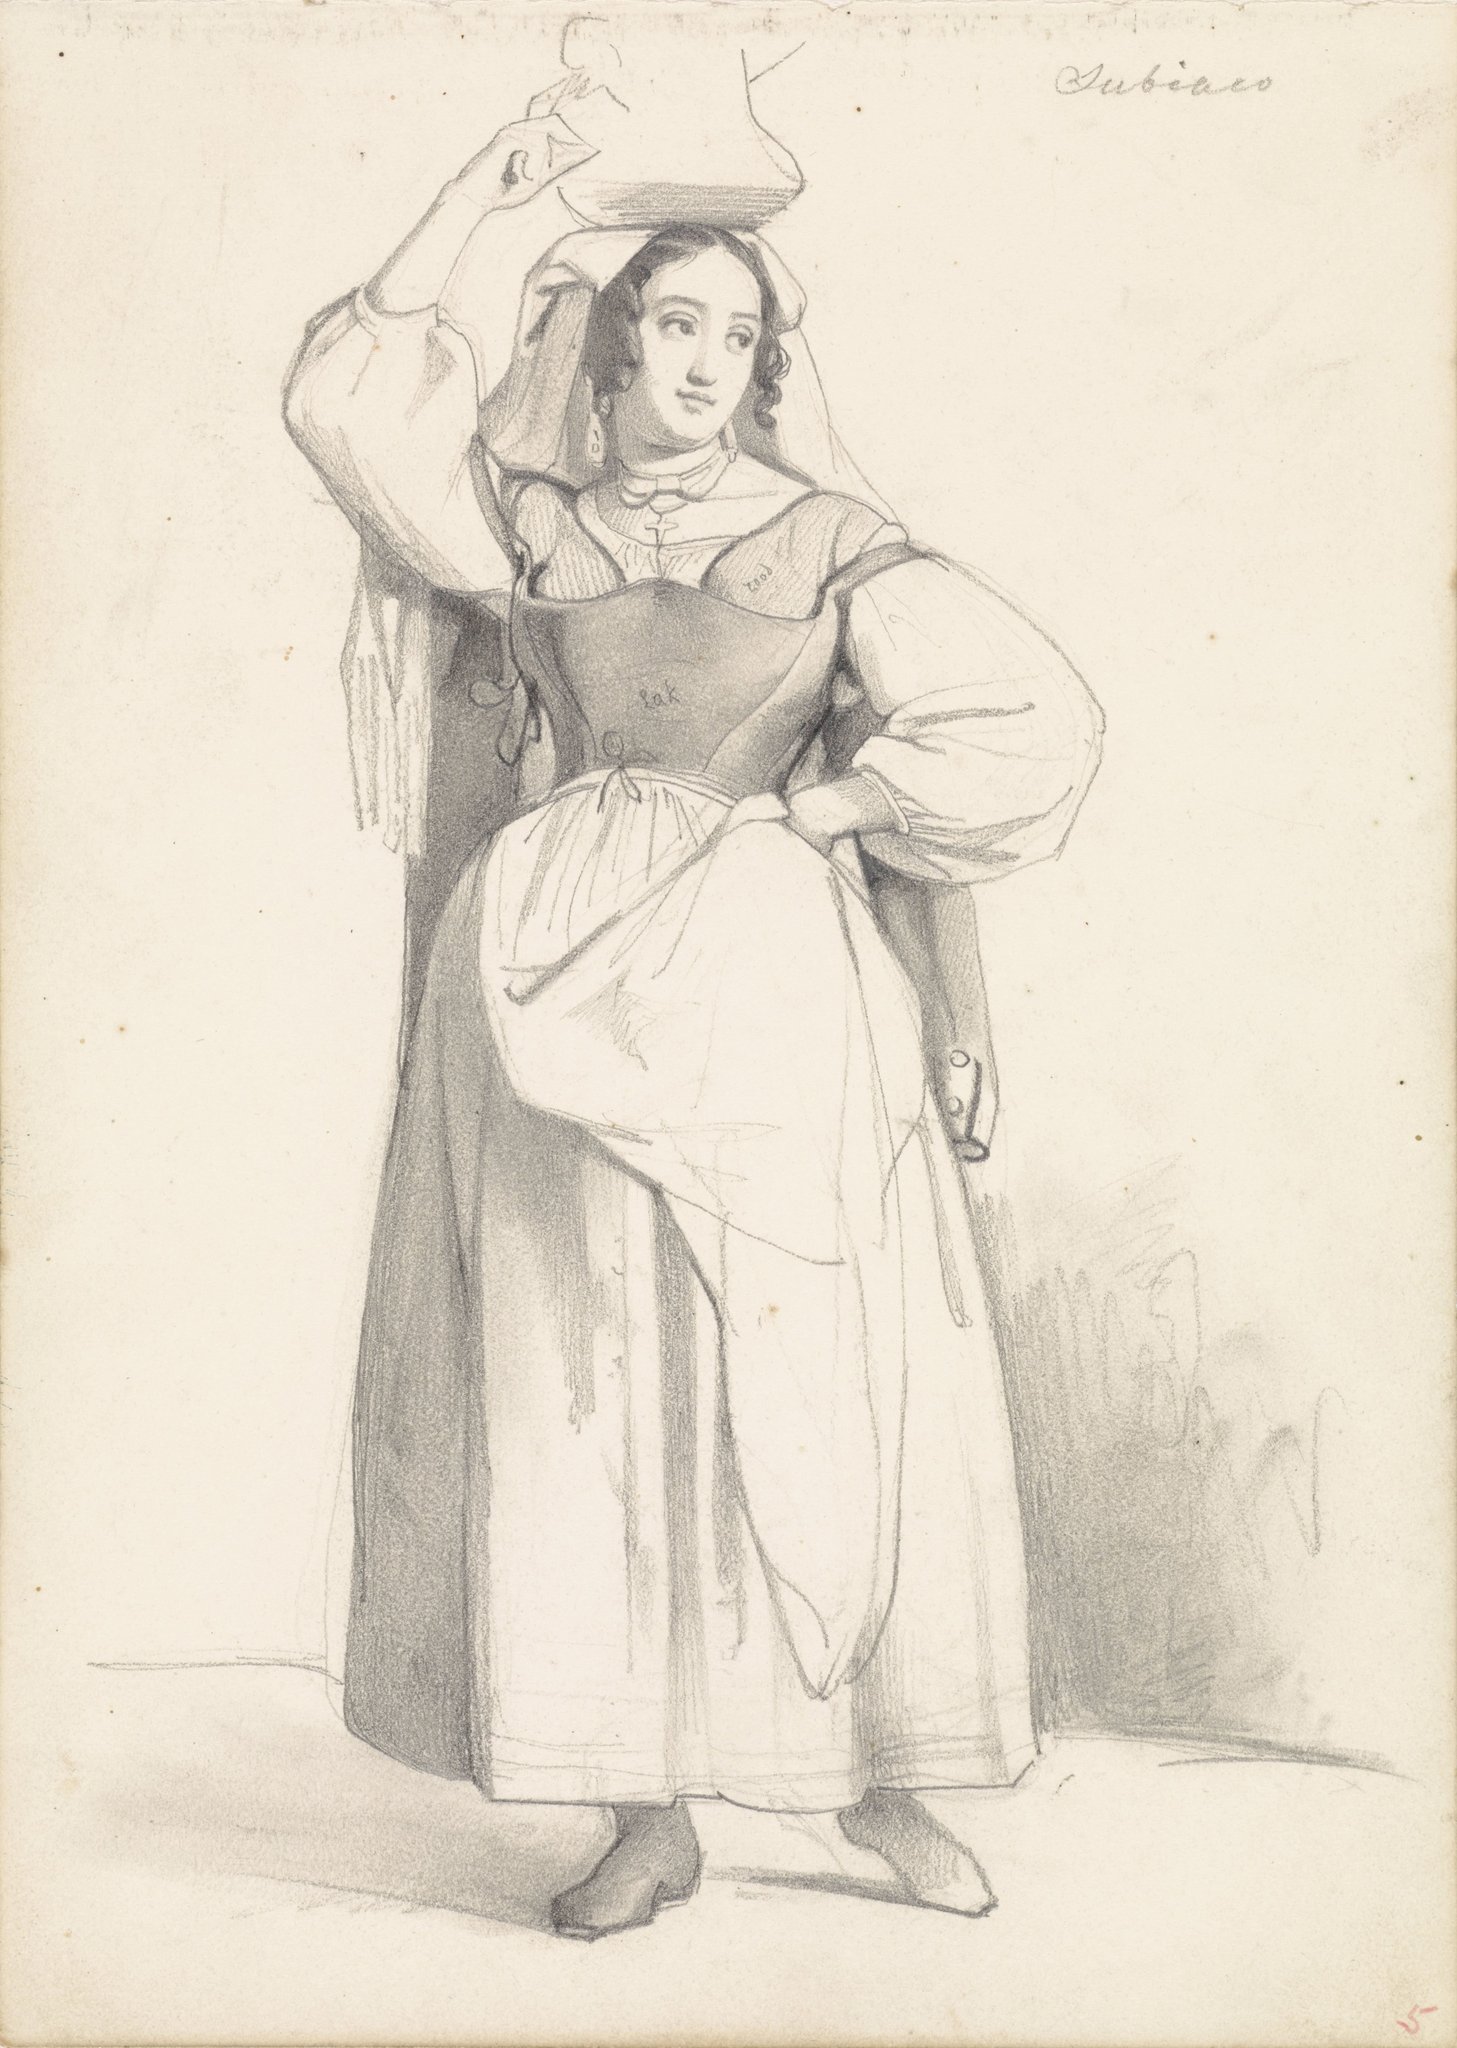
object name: drawing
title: Meisje uit Subiaco, met een koperen kan op het hoofd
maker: johan hendrik koelman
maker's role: draughtsman, print maker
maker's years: 1820-1887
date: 1830-1887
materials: paper, pencil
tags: folk costume, regional costume, italy